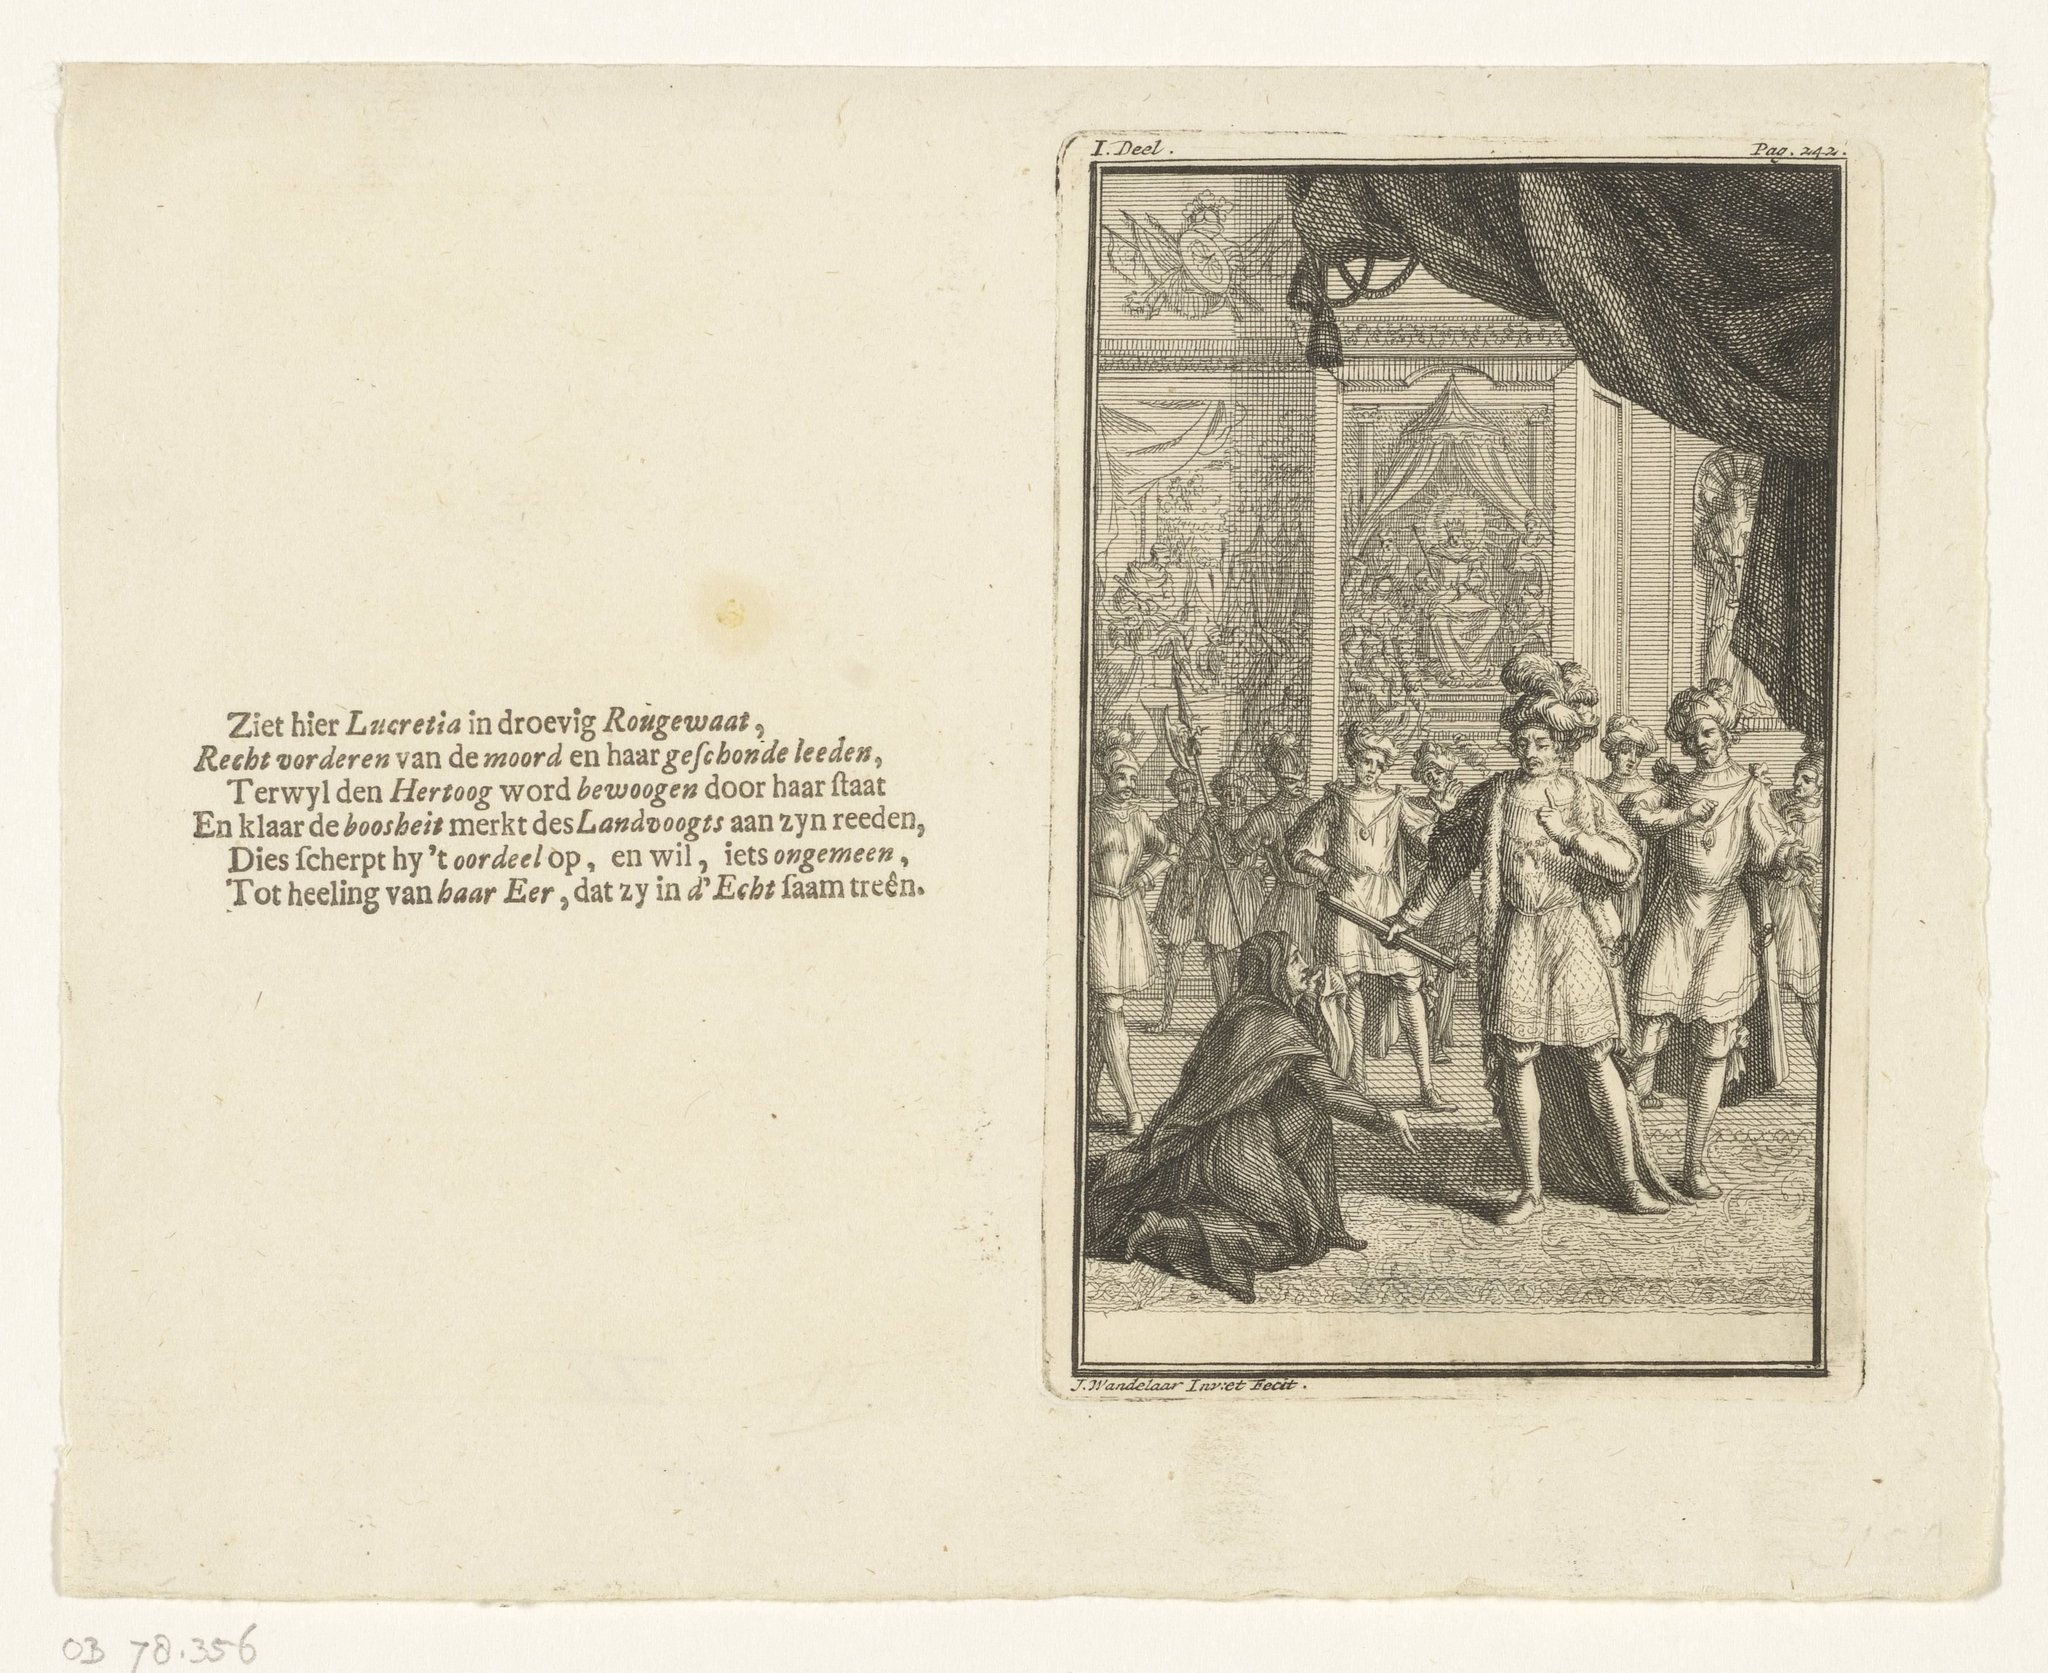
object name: history print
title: Lucretia smeekt de hertog om rechtvaardigheid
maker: jan wandelaar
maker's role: draughtsman, print maker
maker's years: 1690-1759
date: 1700-1759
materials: paper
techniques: engraving, etching, letterpress printing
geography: northern netherlands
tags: juridical examples; exemplary judges; 'gerechtigkeitsbilder', netherlands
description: Scène uit een toneelstuk naar het verhaal van de rechtspraak van Karel de Stoute over de gouverneur van Zeeland, ca. 1474. Ook bekend als het verhaal van Rhynsault en Saphira. In deze bewerking als de landvoogd en Lucretia. Met links van de voorstelling zes regels begeleidende tekst.